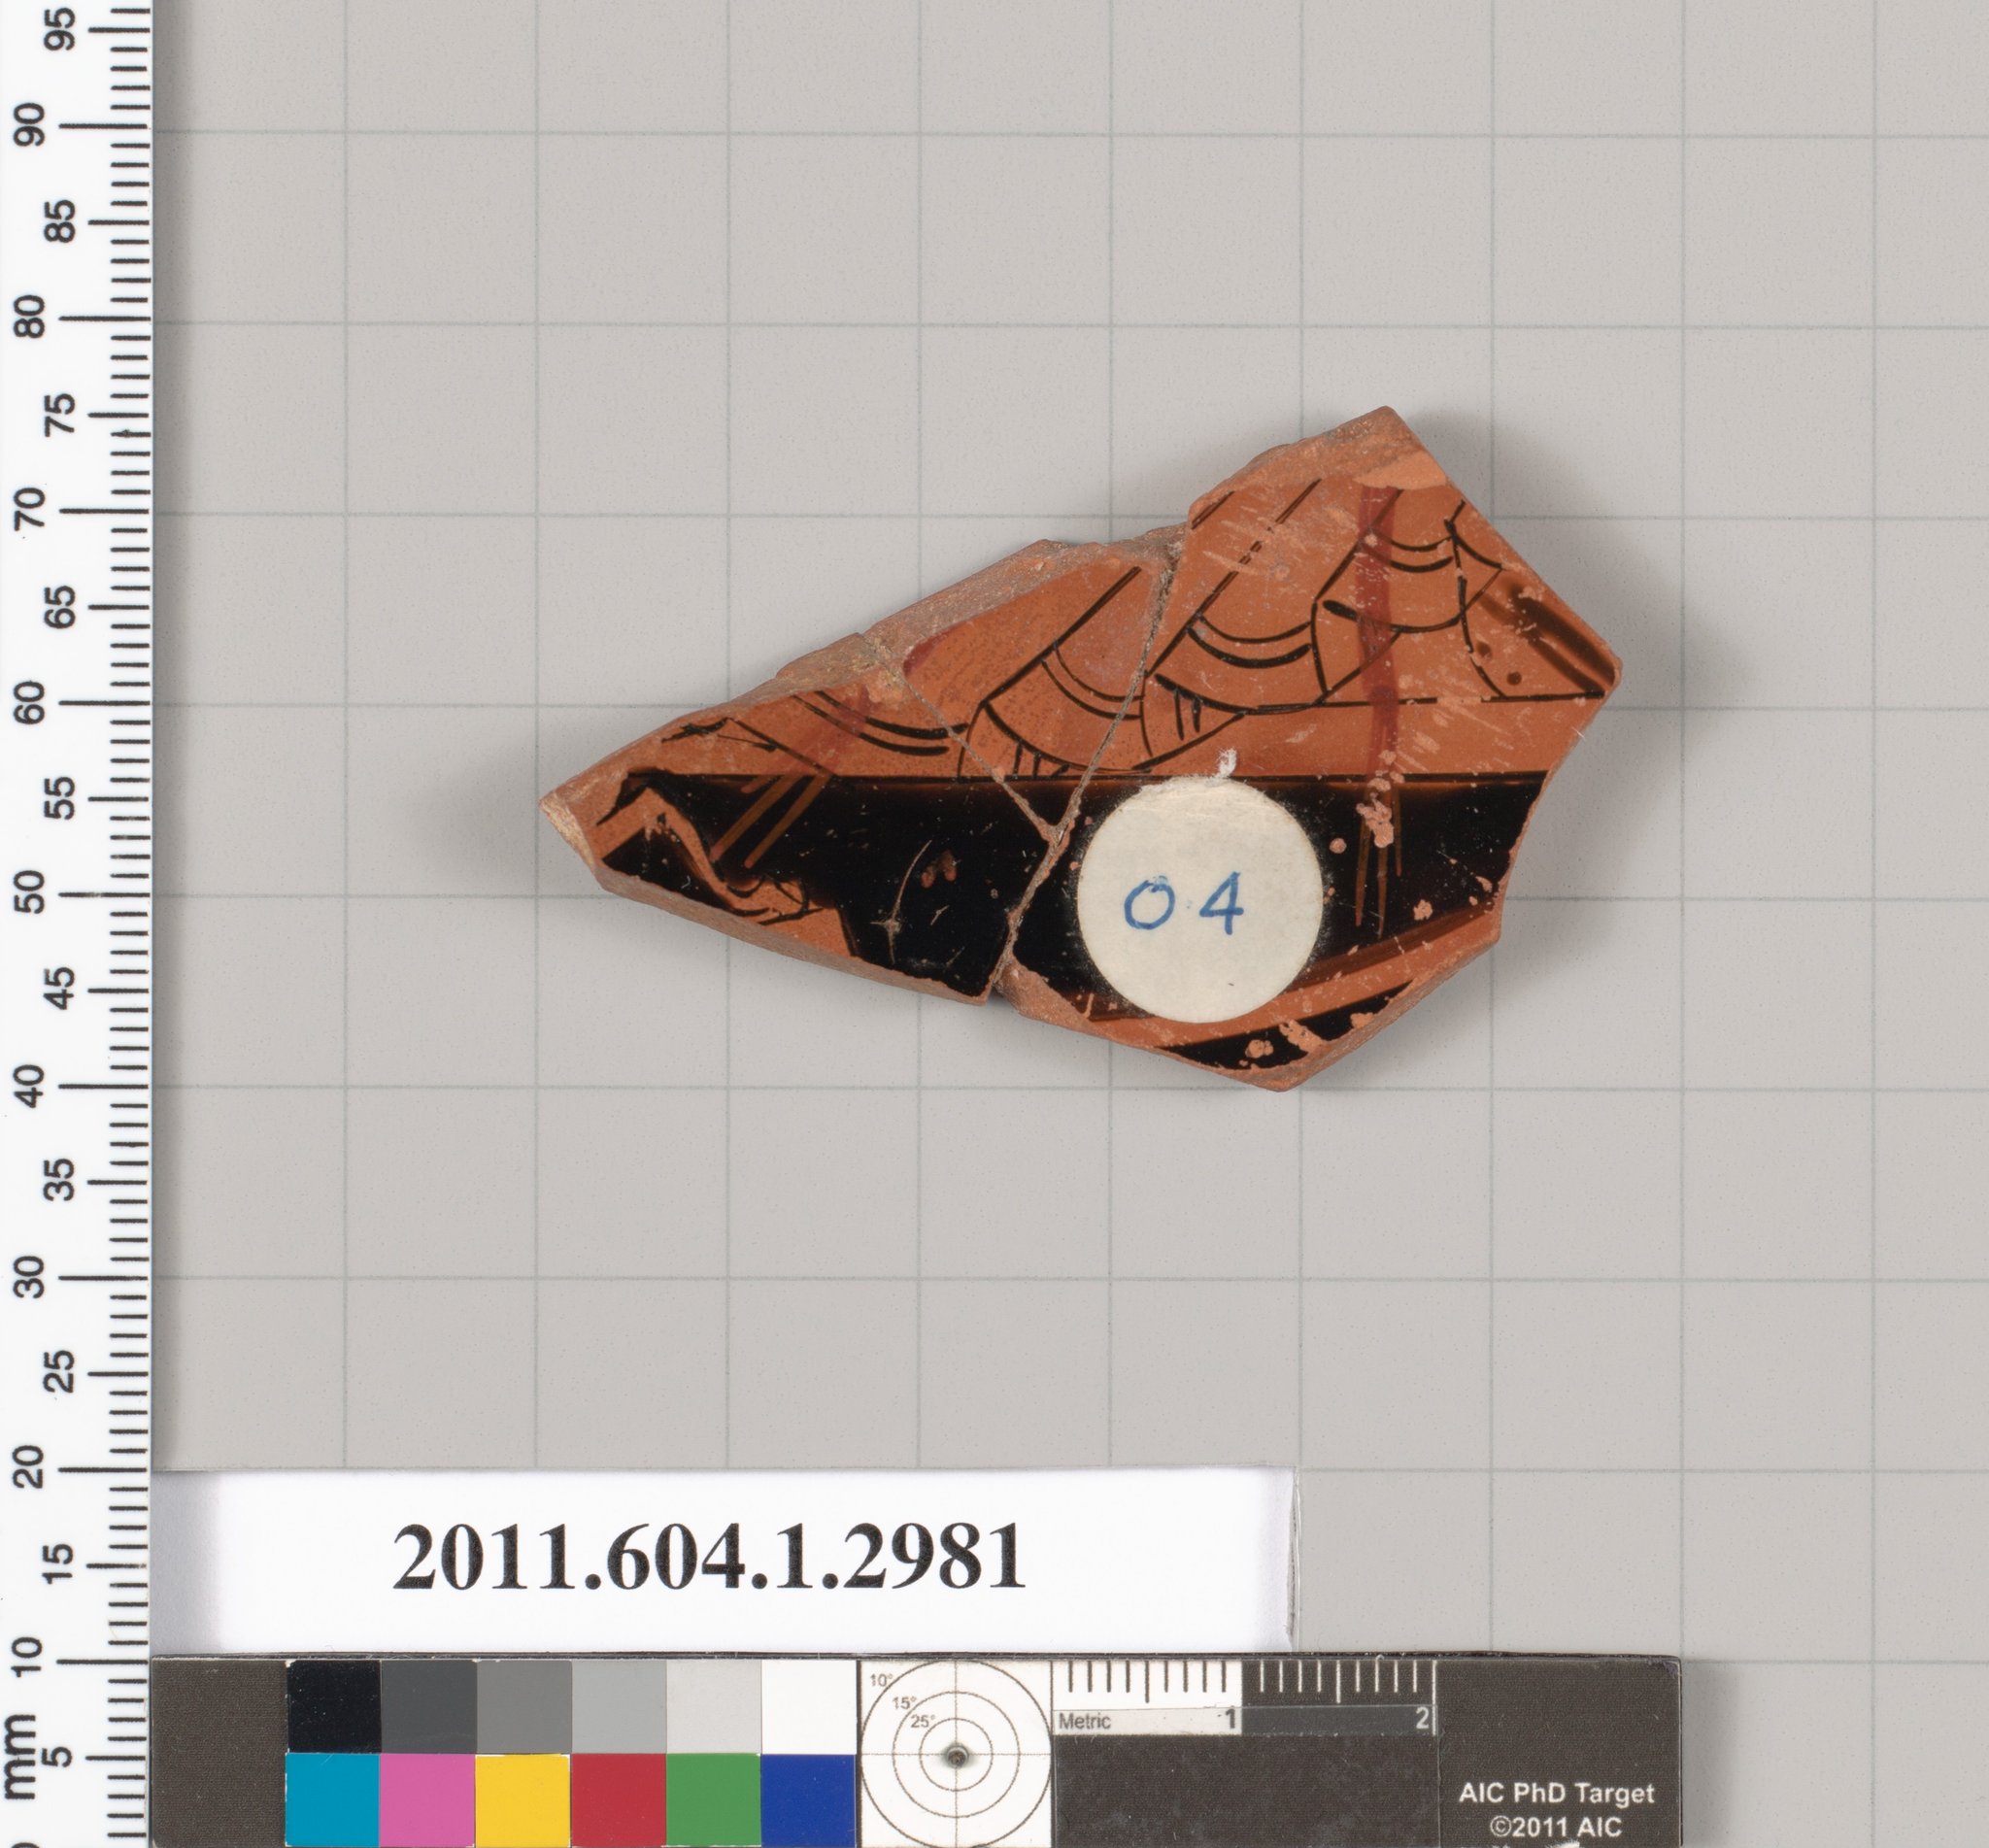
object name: kylix fragment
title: Terracotta fragment of a kylix (drinking cup)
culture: greek, attic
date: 500-490 BCE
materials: terracotta